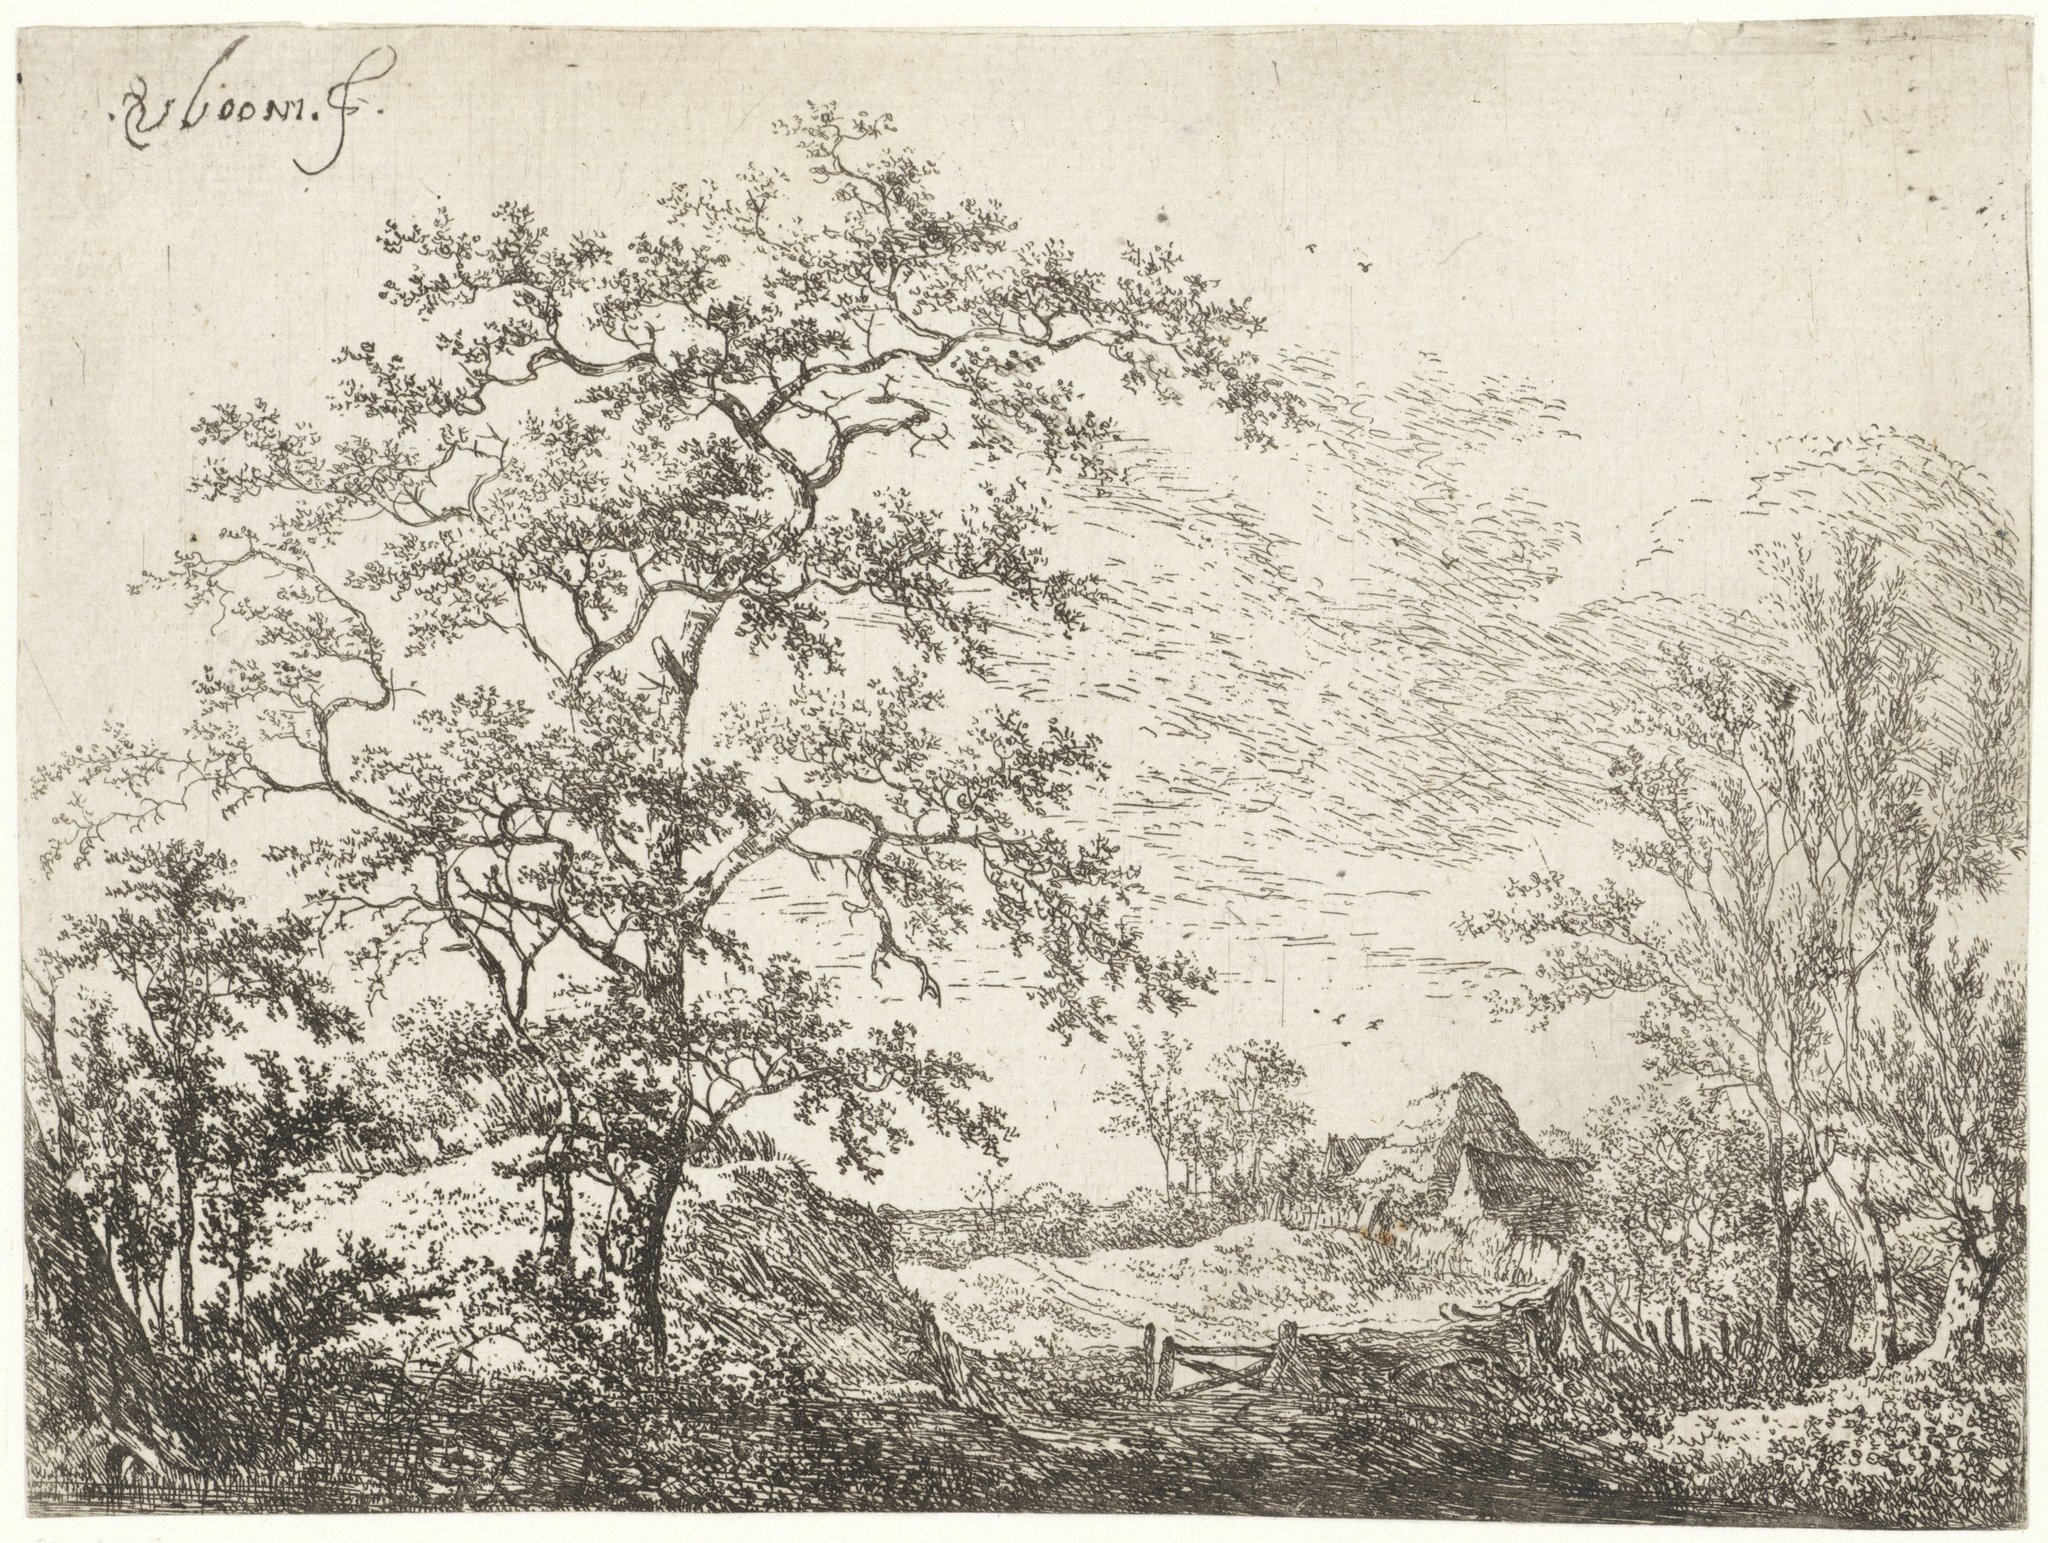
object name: print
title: Farmstead between Trees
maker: adriaen hendriksz. verboom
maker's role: draughtsman, painter, print maker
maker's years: 1627-1680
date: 1637-1673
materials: paper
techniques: etching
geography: northern netherlands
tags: trees, farm or solitary house in landscape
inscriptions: collector's mark: Lugt 240